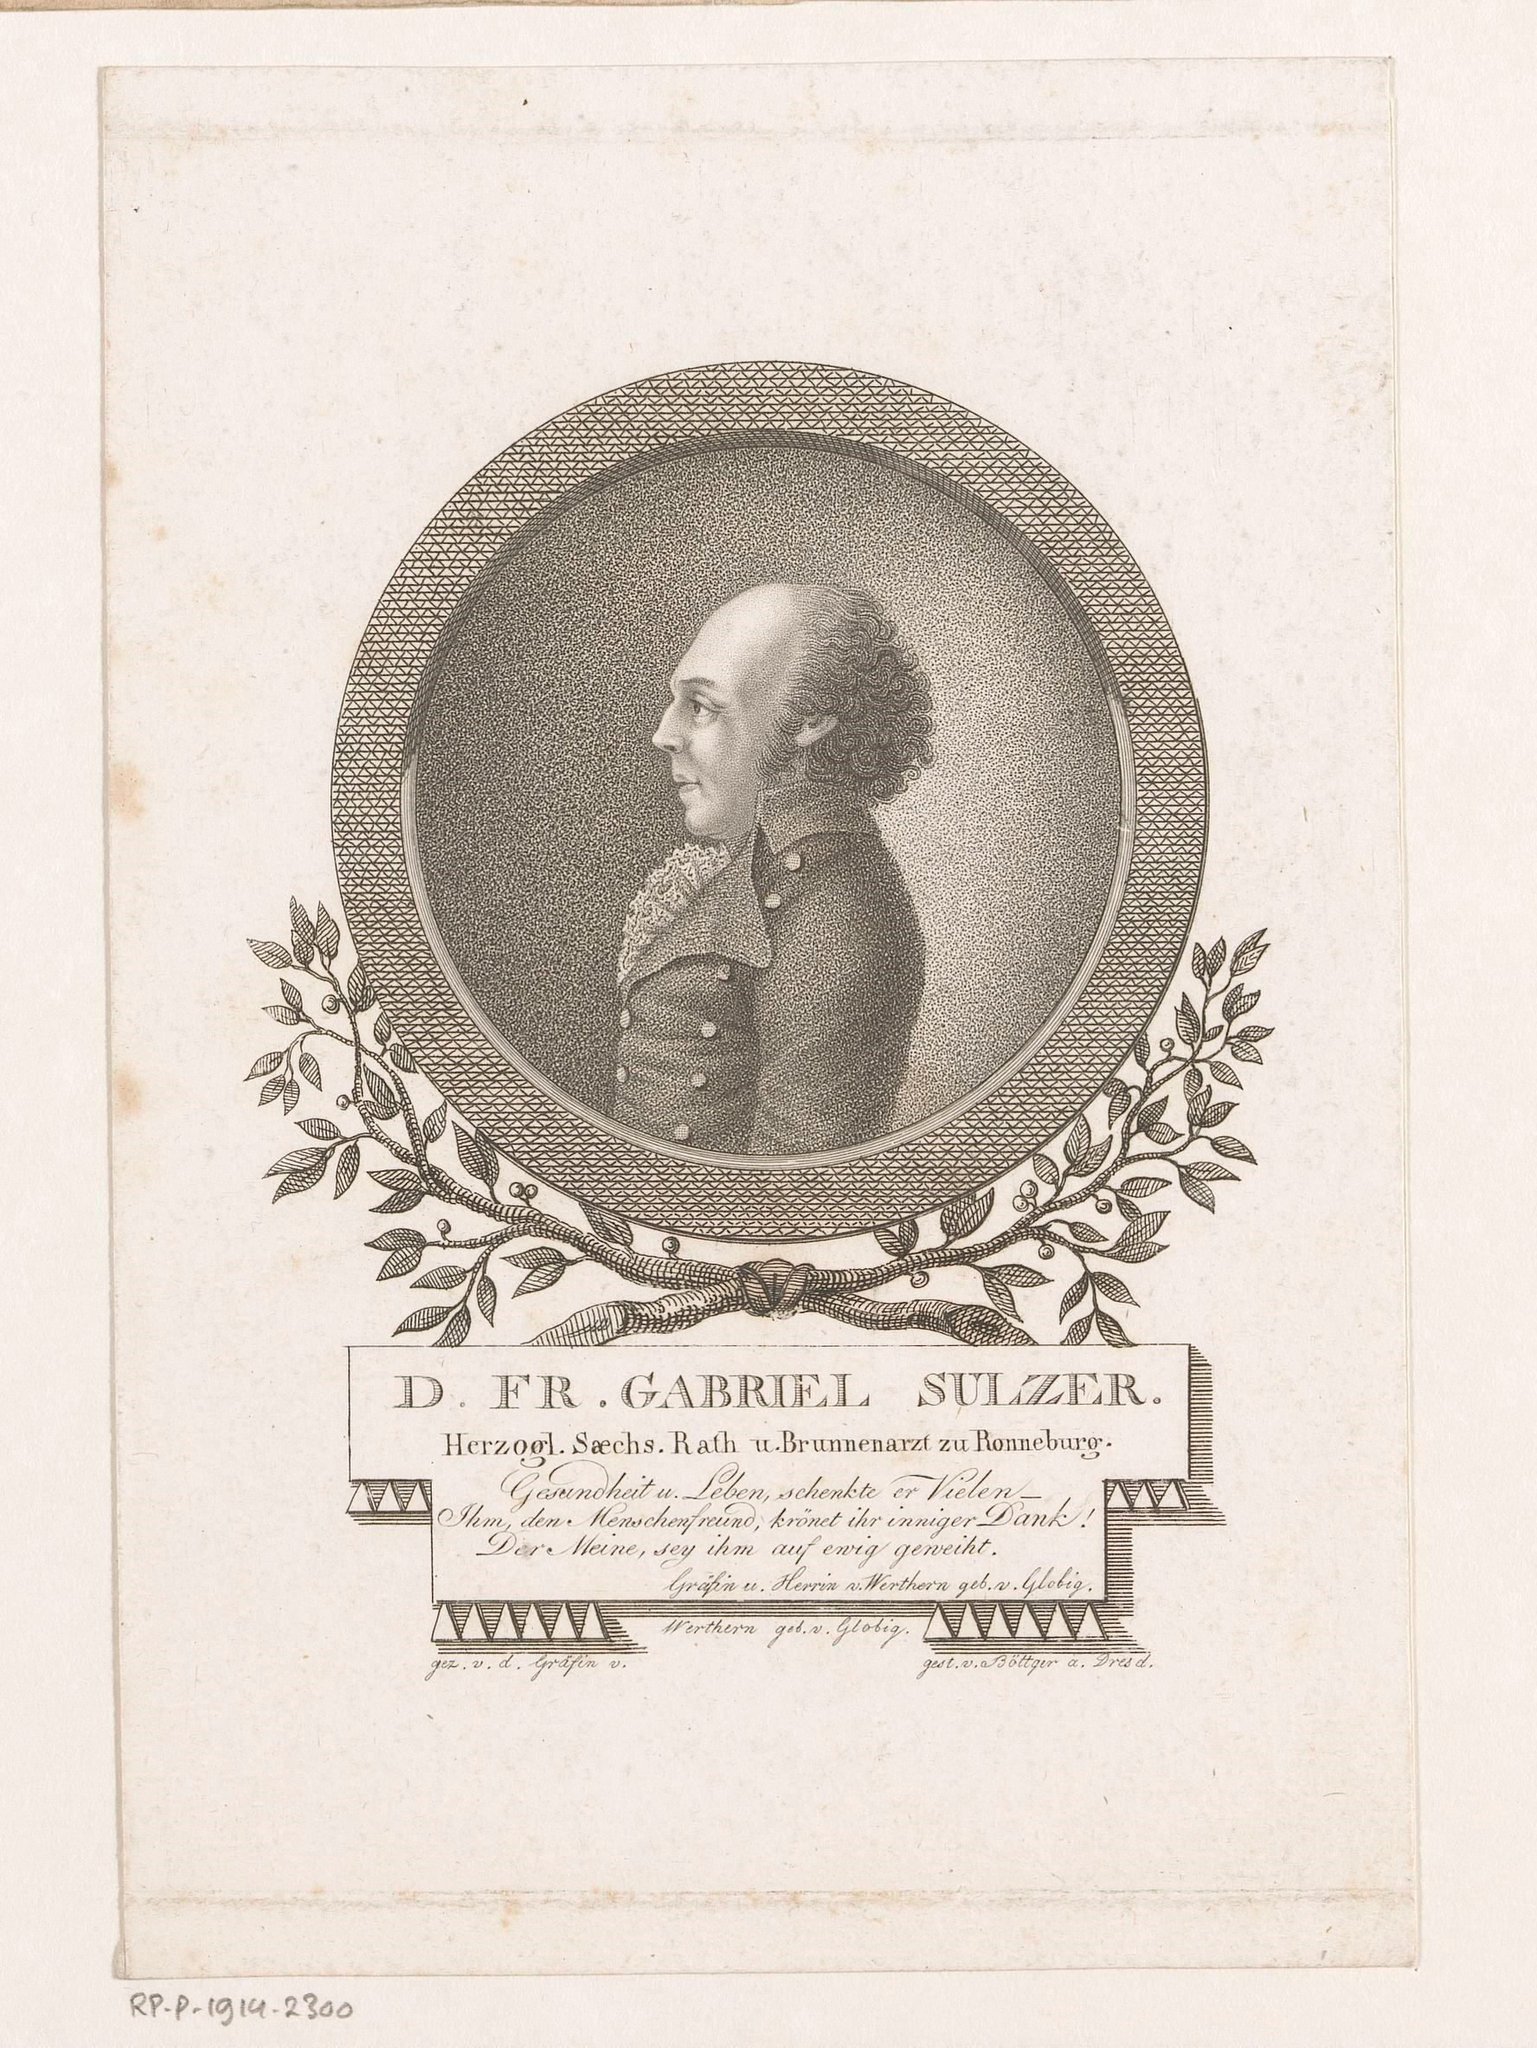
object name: print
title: Portret van Friedrich Gabriel Sulzer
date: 1794-1825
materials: paper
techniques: etching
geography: leipzig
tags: friedrich gabriel sulzer, historical persons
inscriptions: collector's mark: Lugt 2228